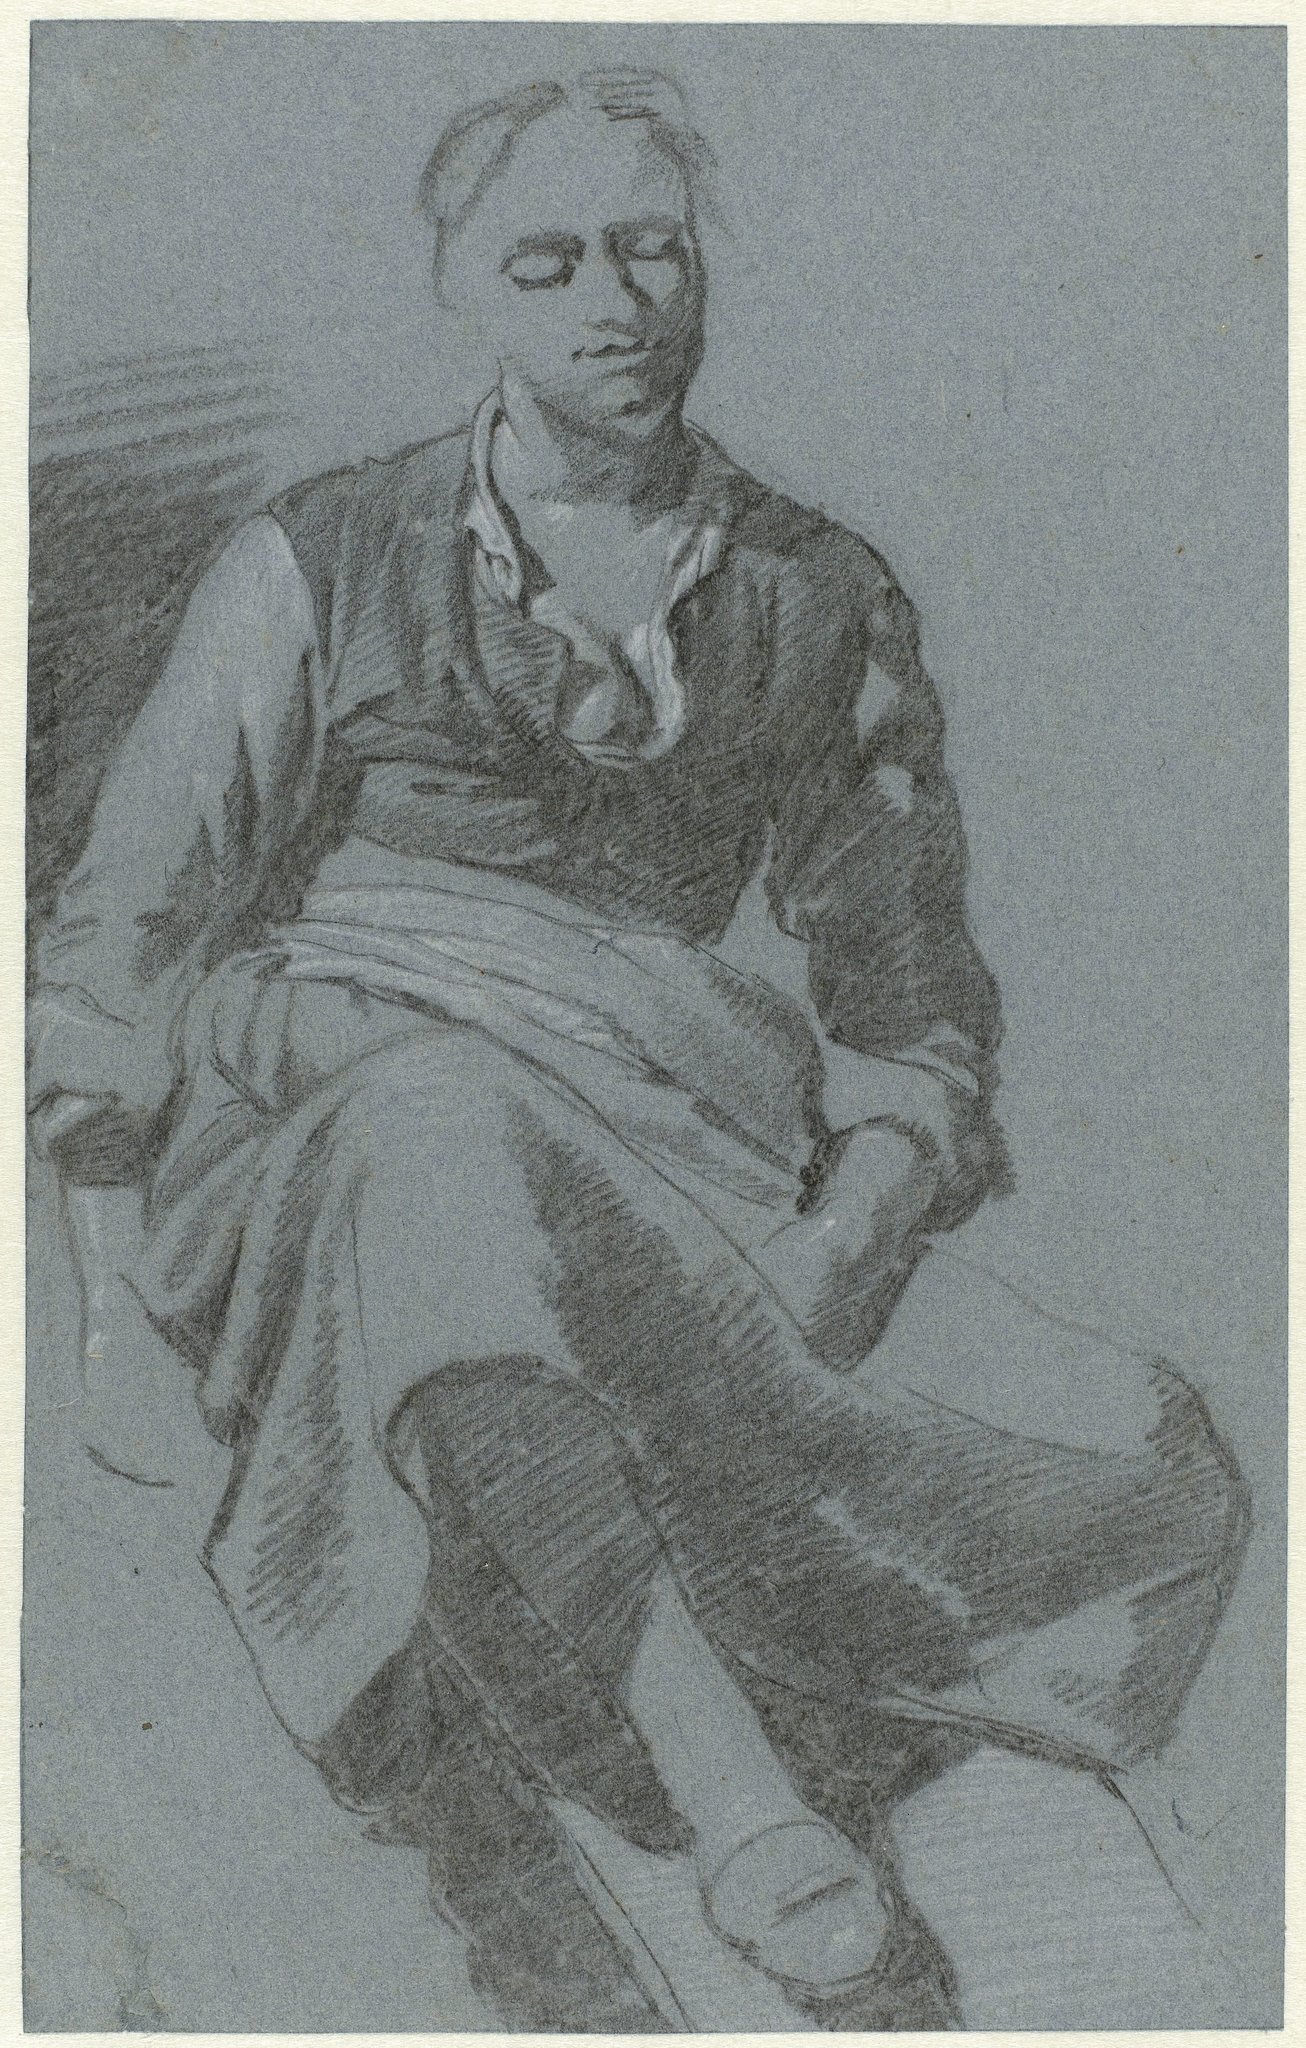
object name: drawing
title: Seated Woman, her Left Hand in her Lap and her Right Leg Pulled Up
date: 1641-1664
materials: chalk, paper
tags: sitting figure - aa - female human figure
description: Een zittende vrouw met de linkerhand in haar schoot en het rechterbeen uitgestrekt.